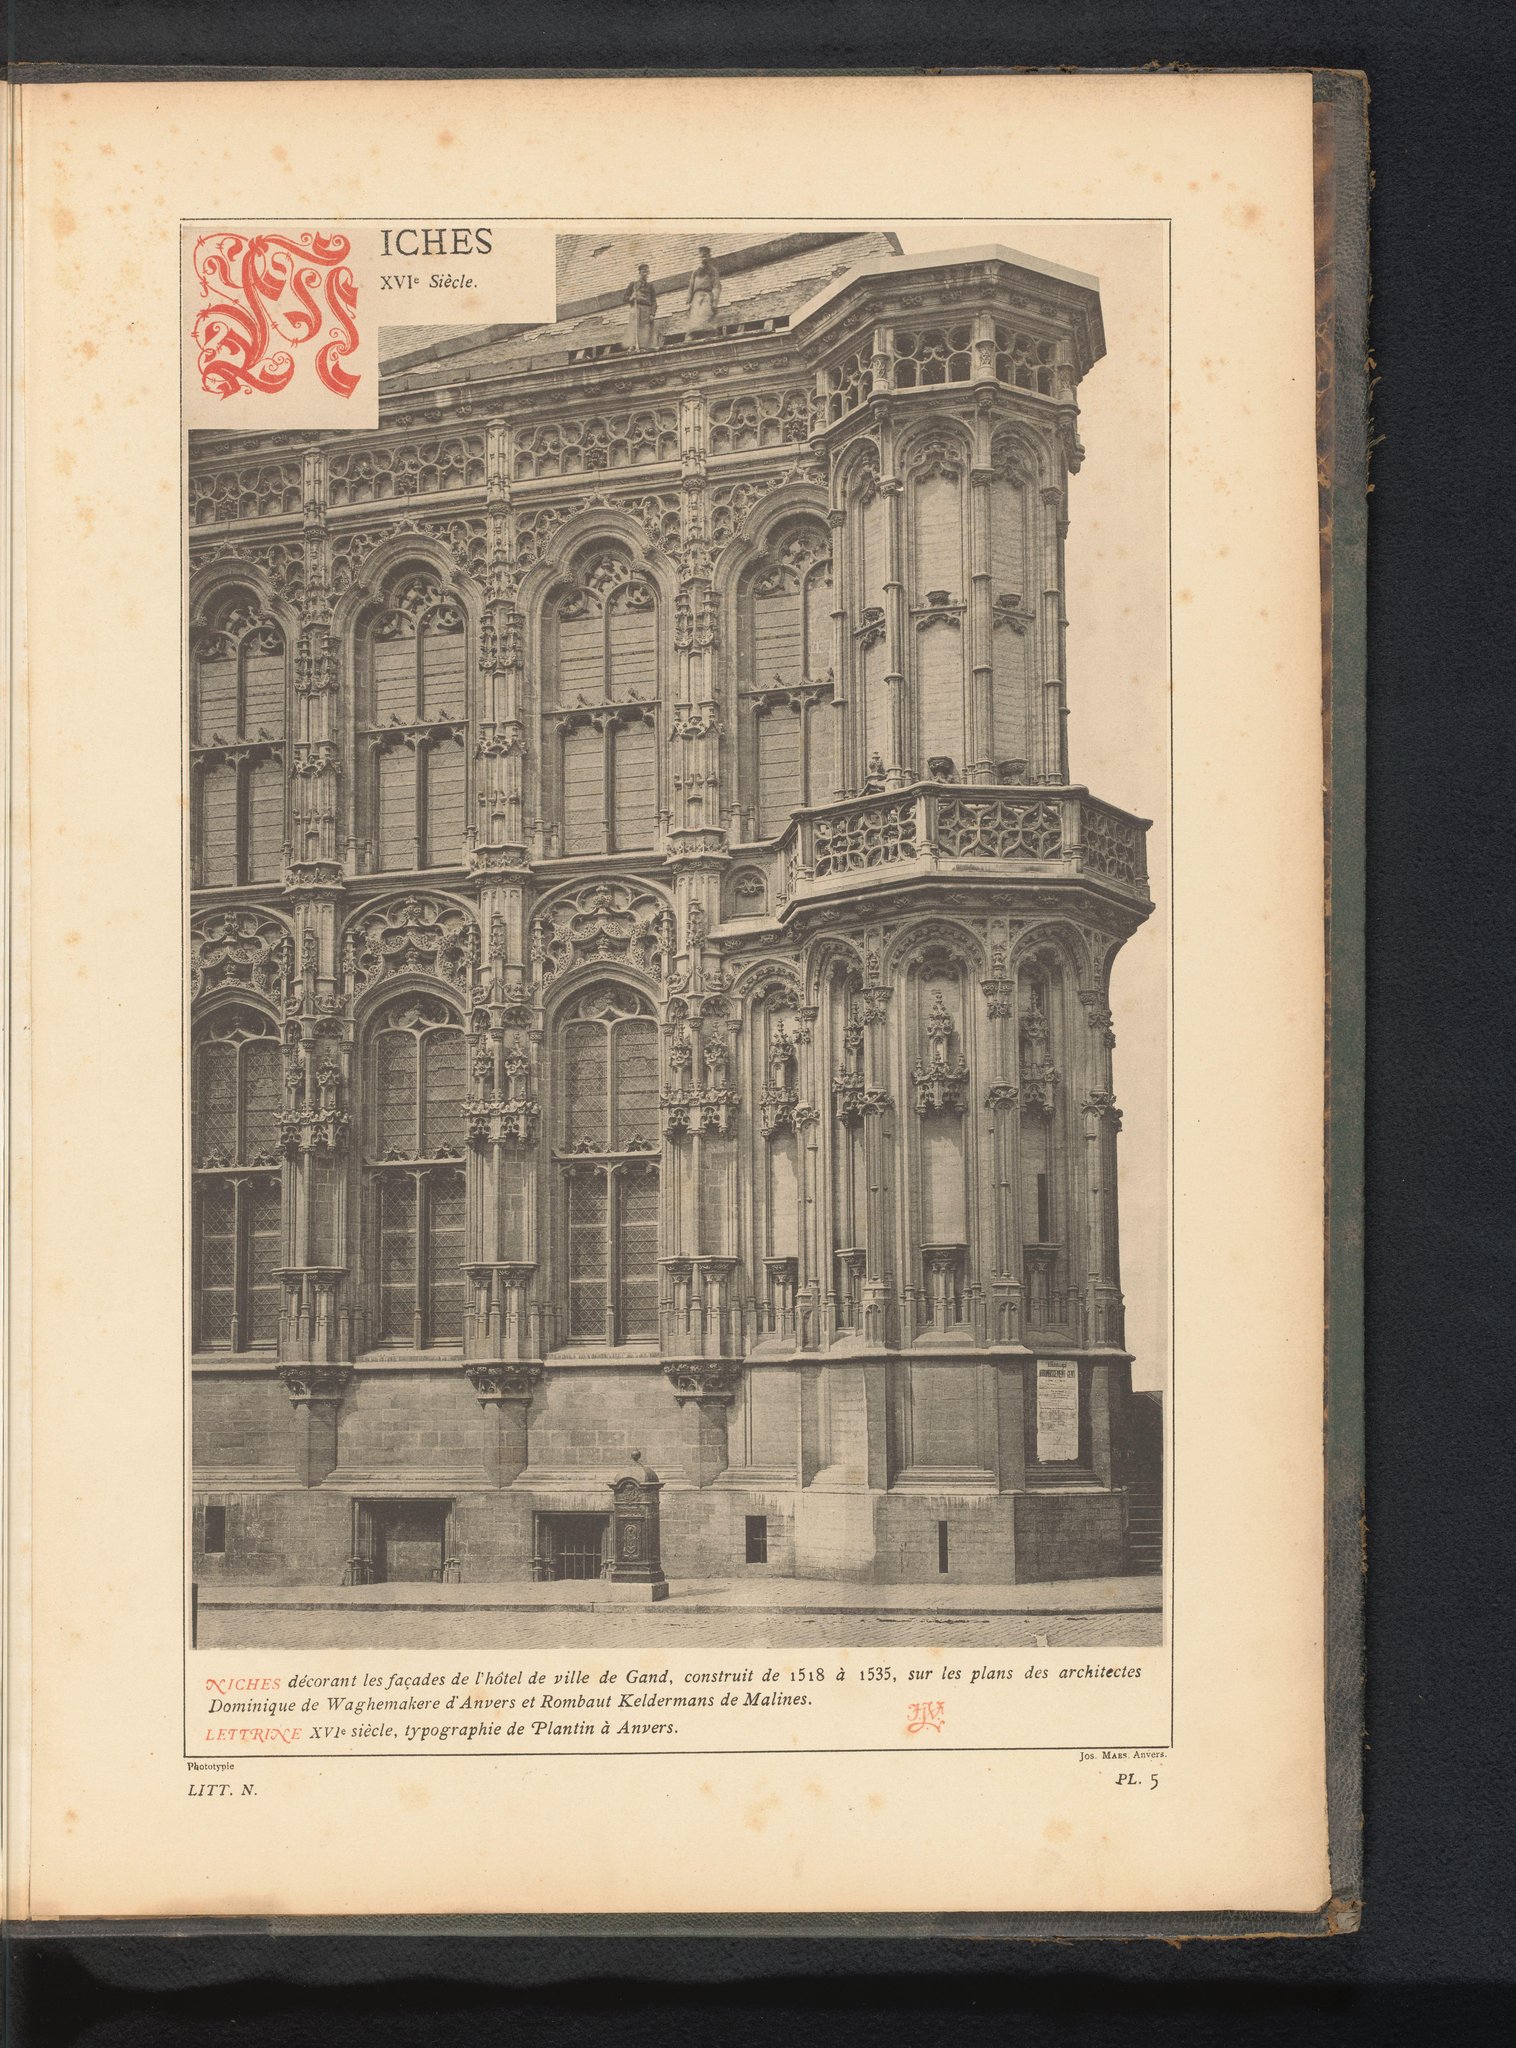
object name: photomechanical print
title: Gezicht op een deel van het stadhuis van Gent, België, met gedecoreerde nissen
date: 1875-1880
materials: paper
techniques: photograph, photolithography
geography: antwerp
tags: townhall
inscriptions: inscription: ‘LITT. N. - PL. 5’, monogram: ‘JJvY’, inscription: ‘NICHES décorant les (...)’